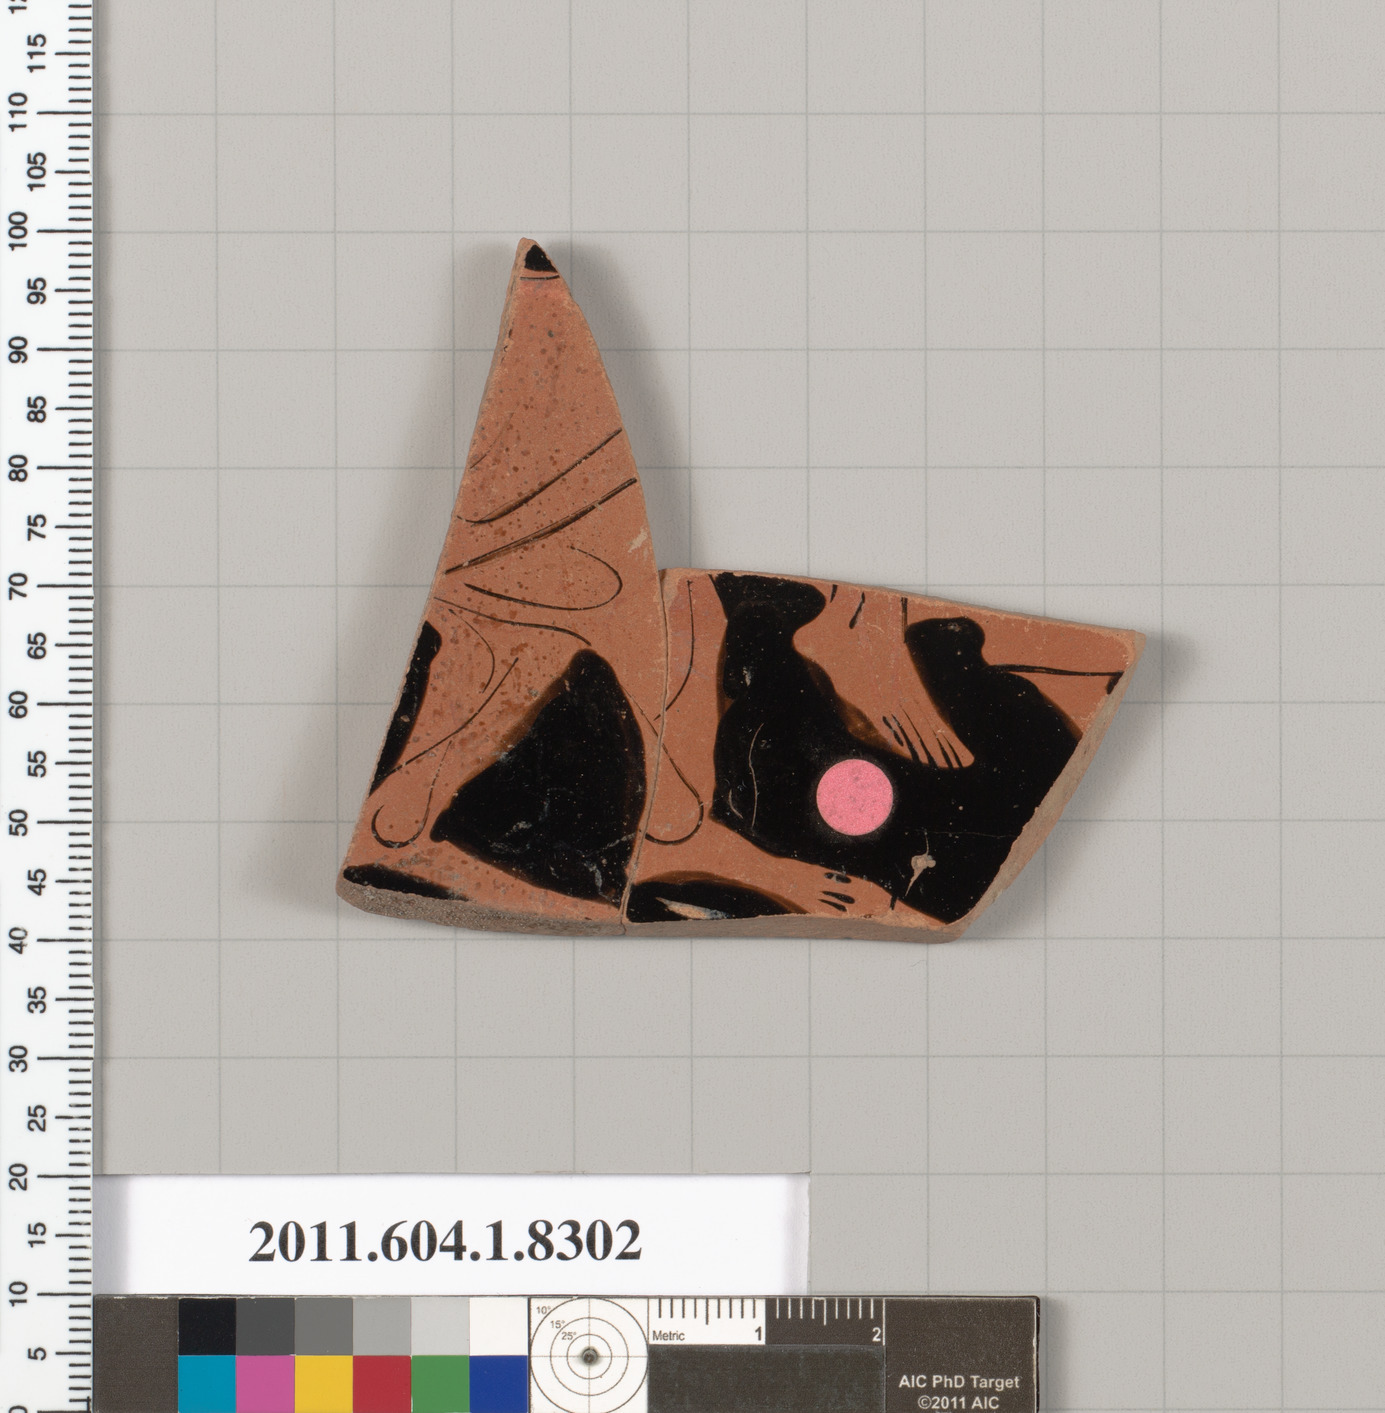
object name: kylix fragment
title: Terracotta fragment of a kylix (drinking cup)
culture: greek, attic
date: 400-351 BCE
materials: terracotta